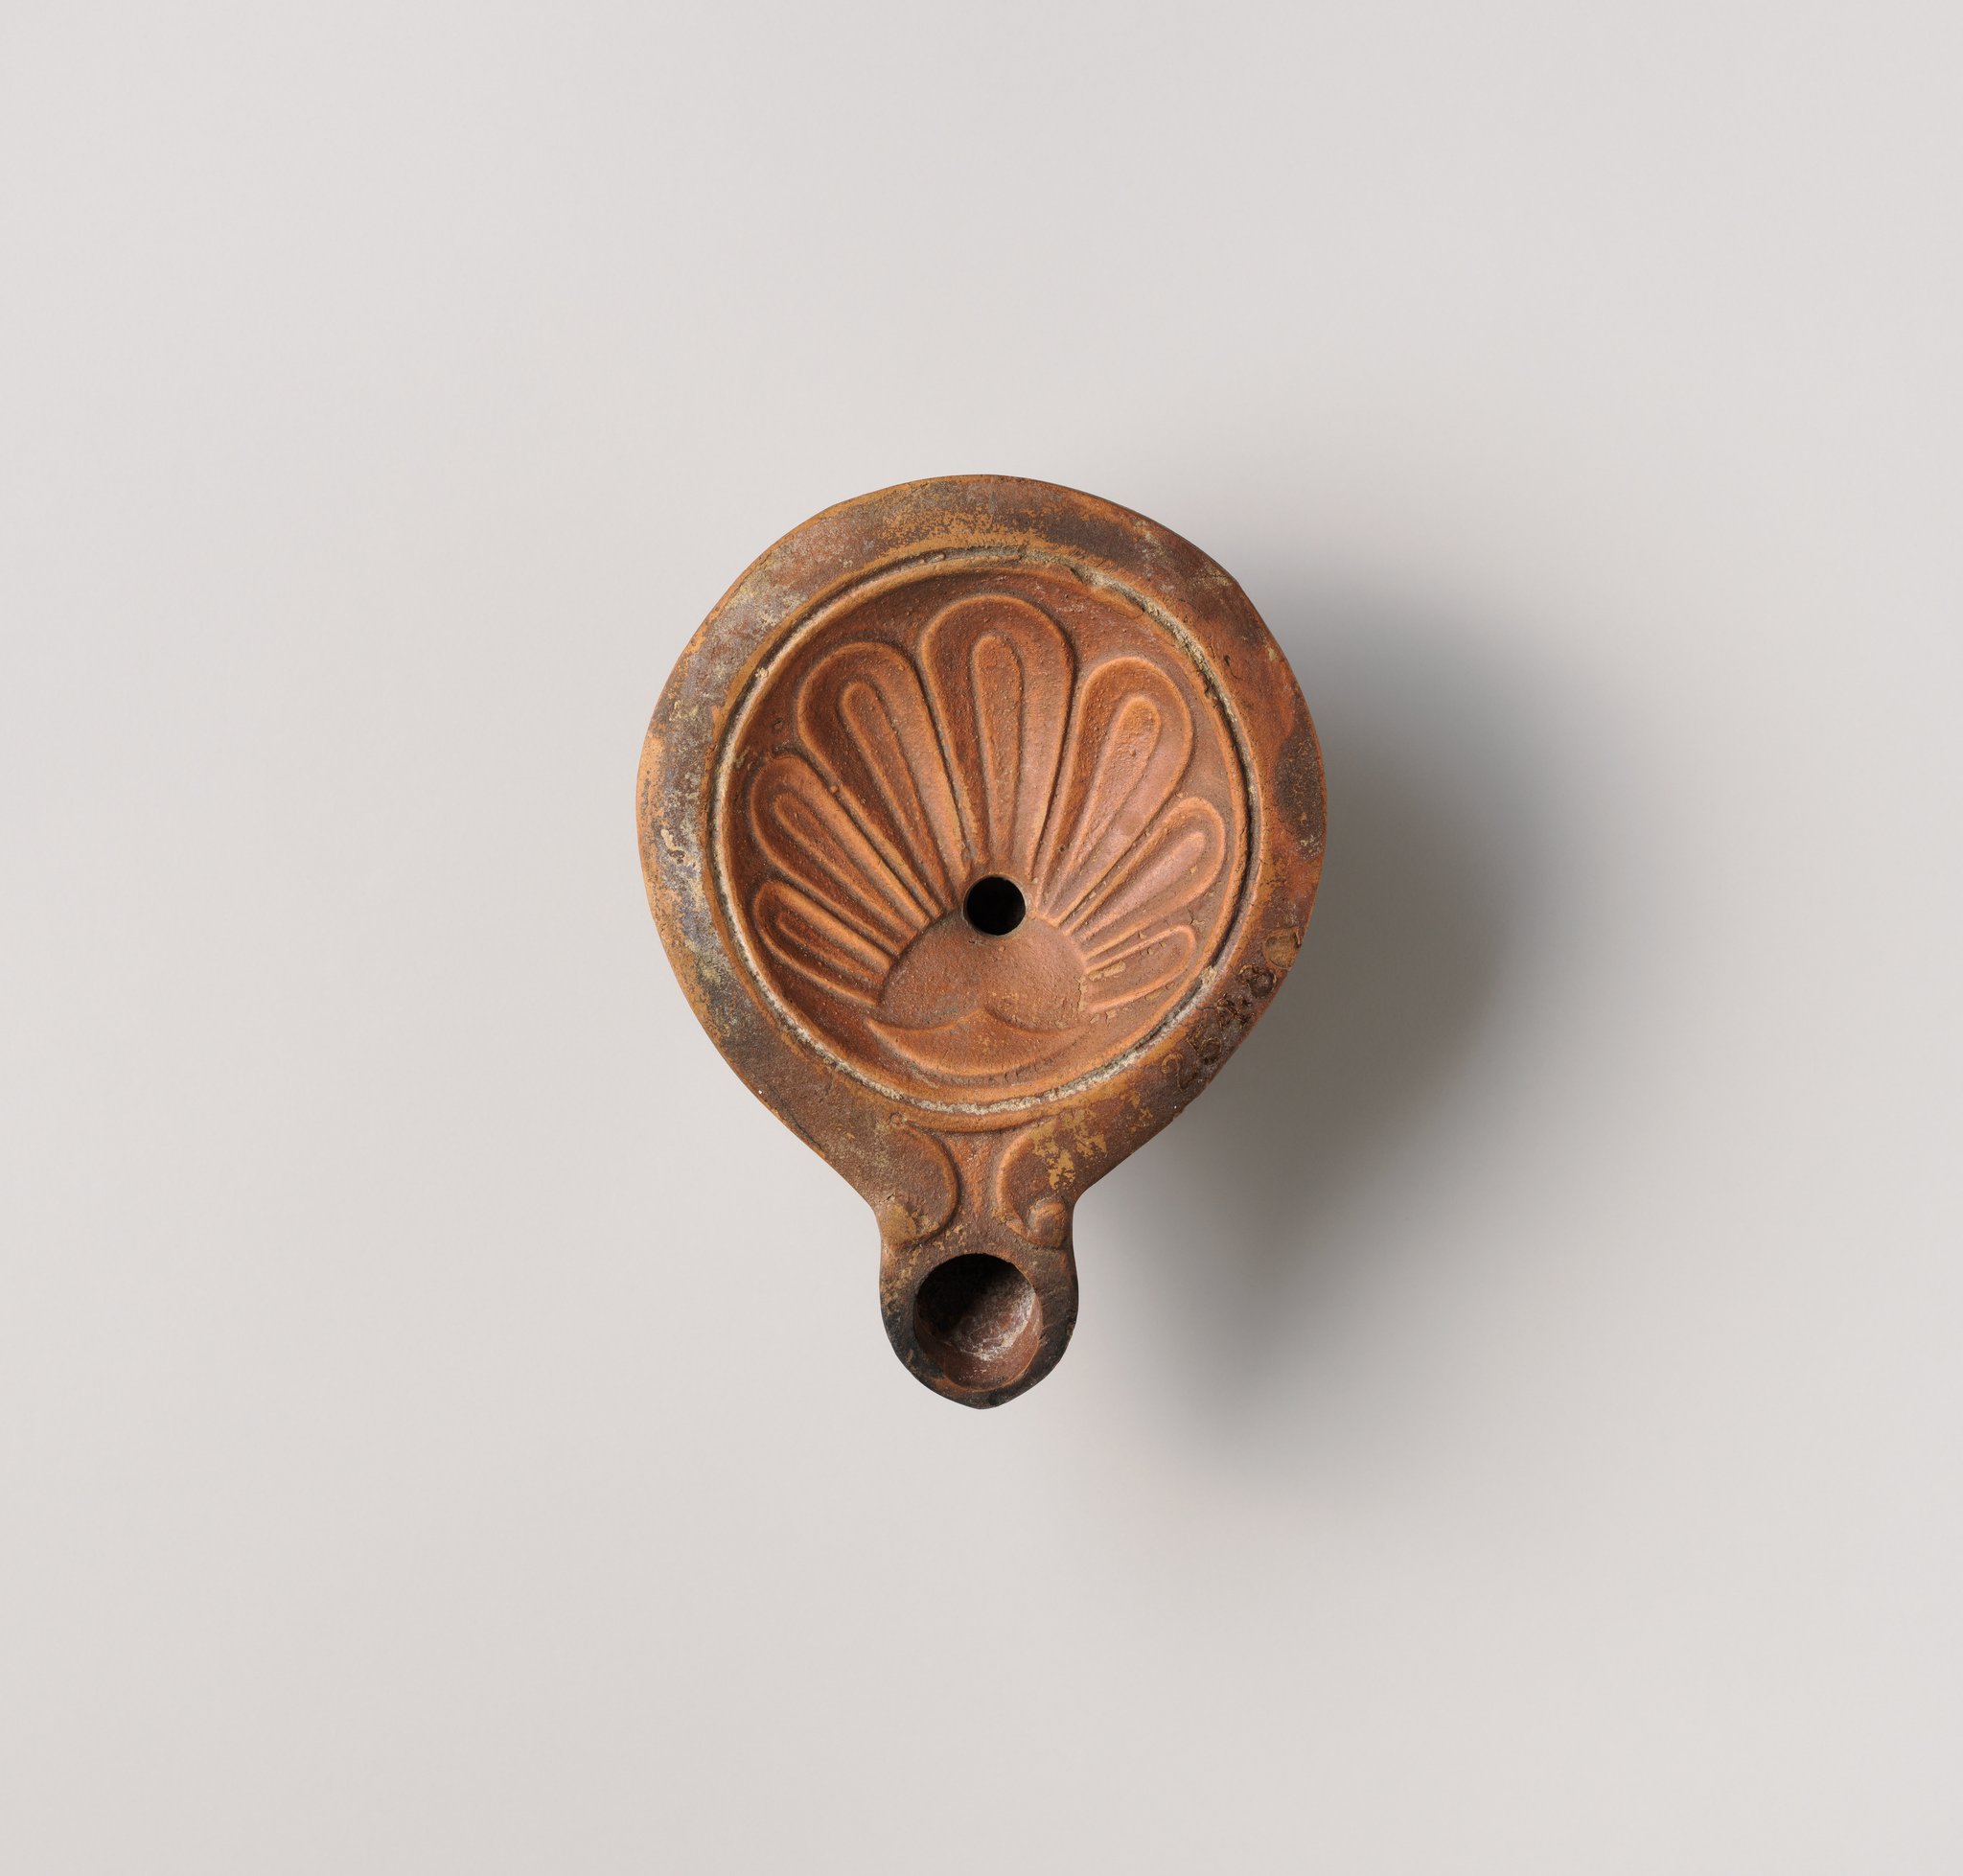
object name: lamp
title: Terracotta oil lamp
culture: roman, cypriot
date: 50-100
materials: terracotta